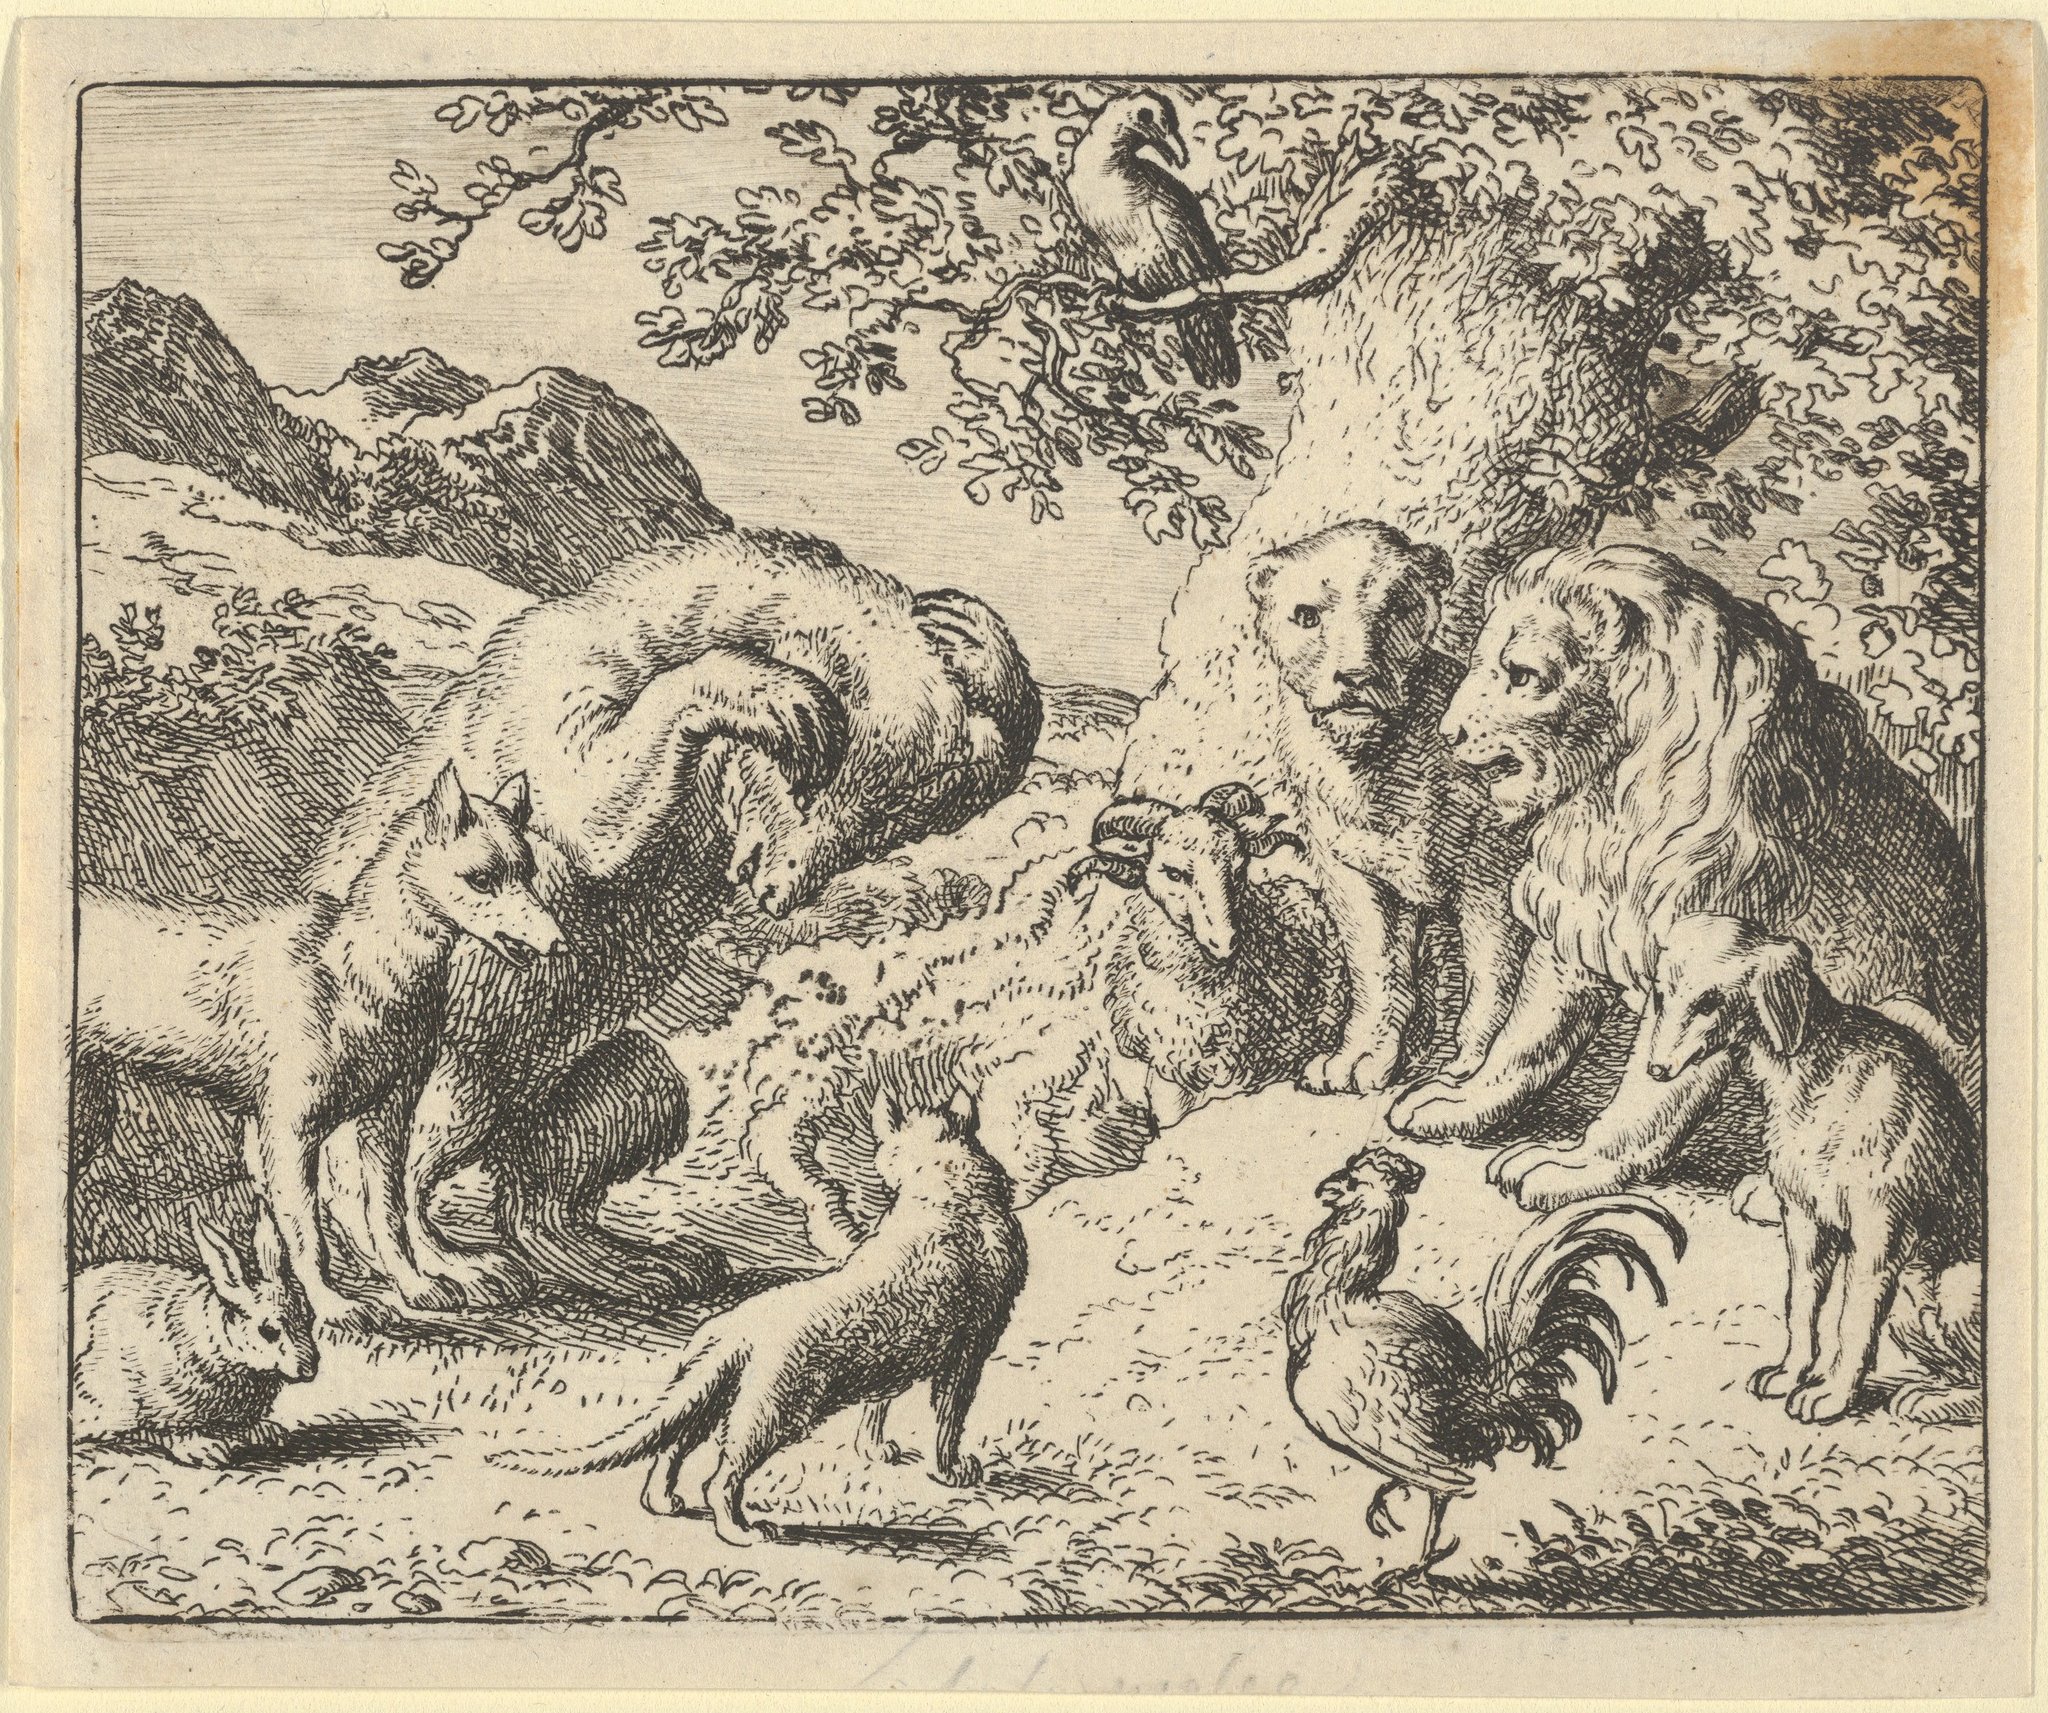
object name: print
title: The Bear Seeks Justice from the Lion Against Renard from Hendrick van Alcmar's Renard The Fox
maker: allart van everdingen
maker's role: artist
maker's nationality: dutch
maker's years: 1621-1675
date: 1650-1675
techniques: engraving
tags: bears,chickens,dogs,foxes,lions,rabbits